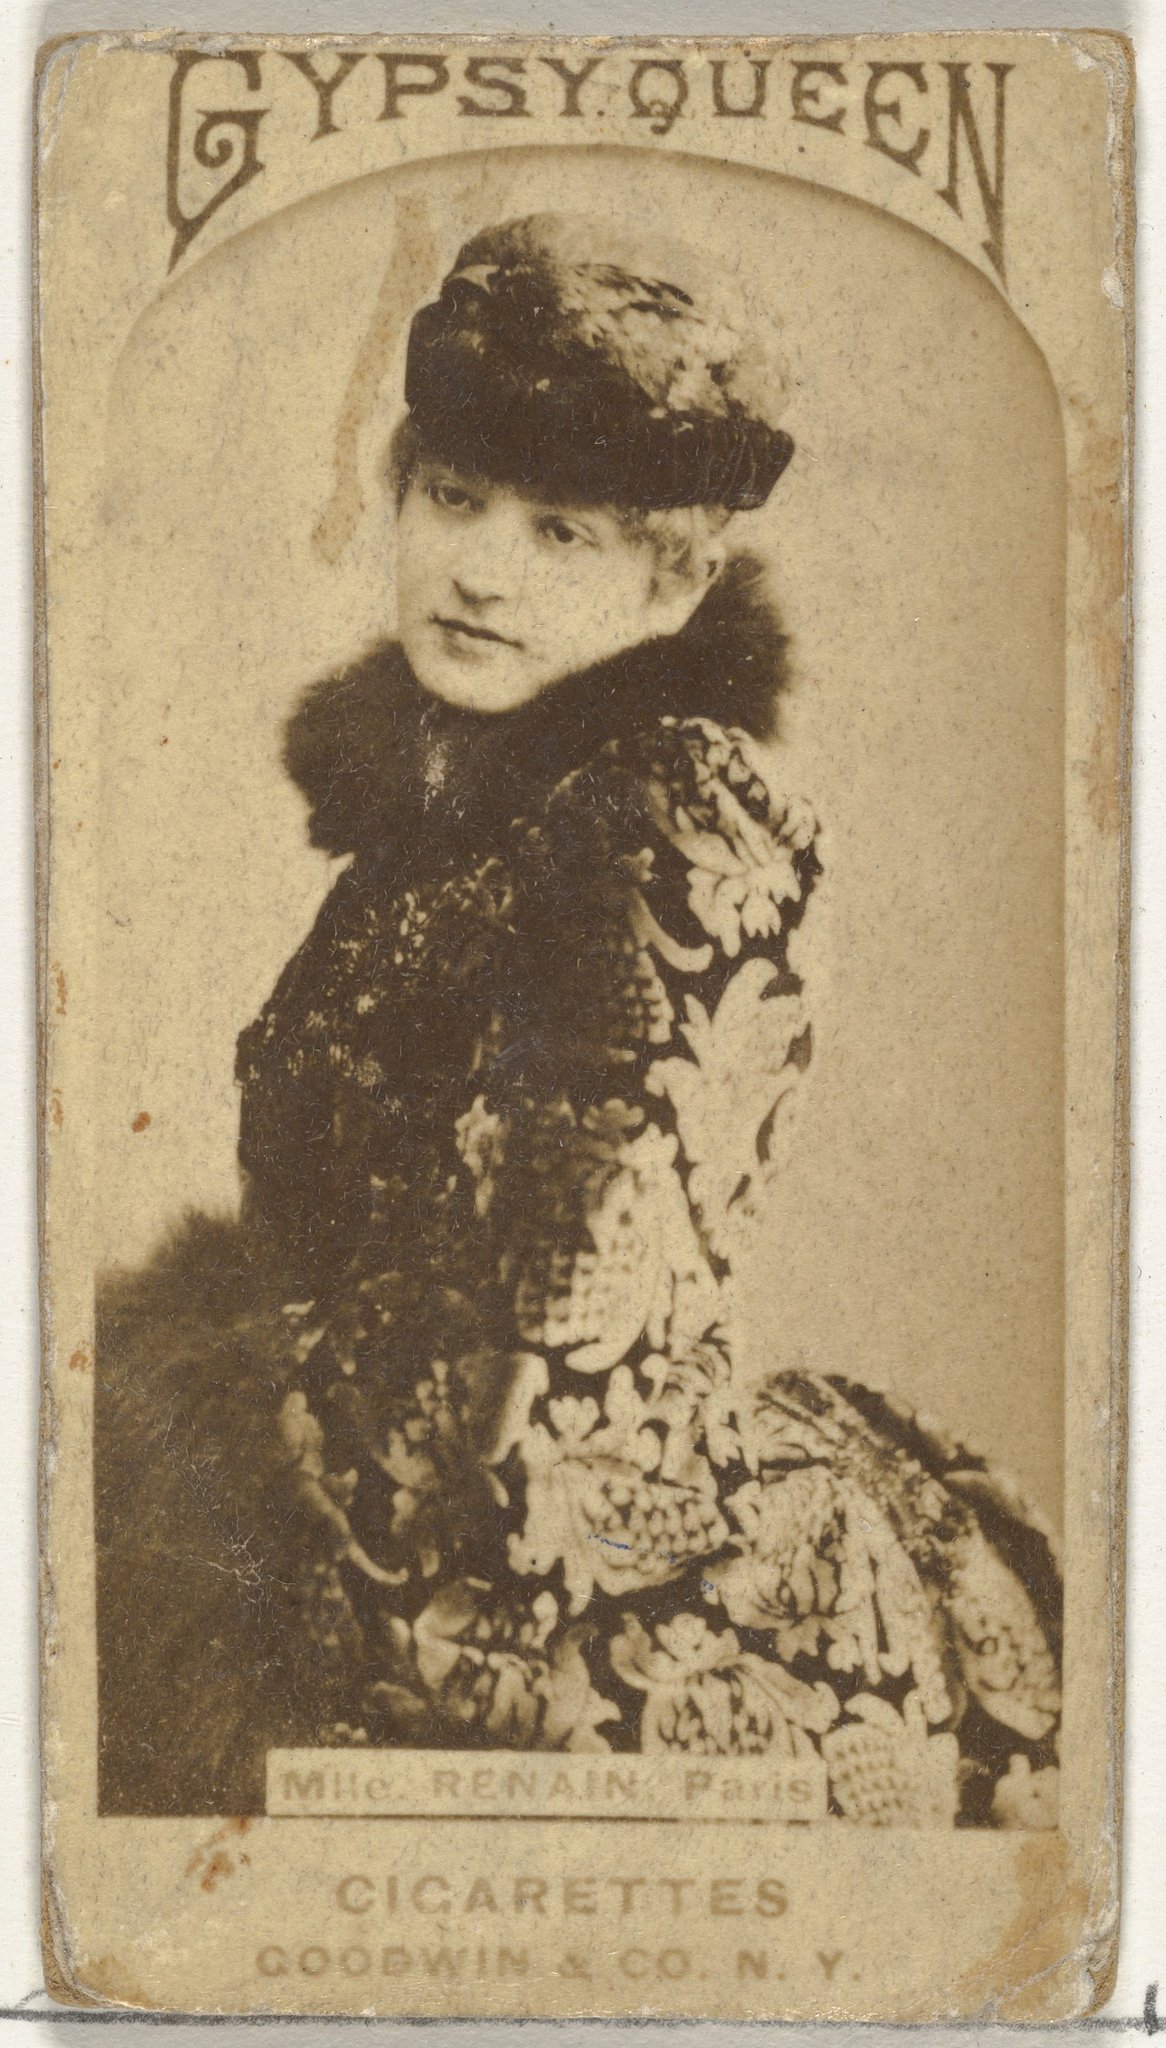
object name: photograph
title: Mlle. Renain, Paris, from the Actors and Actresses series (N171) for Gypsy Queen Cigarettes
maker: goodwin & company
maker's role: publisher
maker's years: 1850-1950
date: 1886-1890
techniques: albumen silver print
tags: portraits,women,actresses